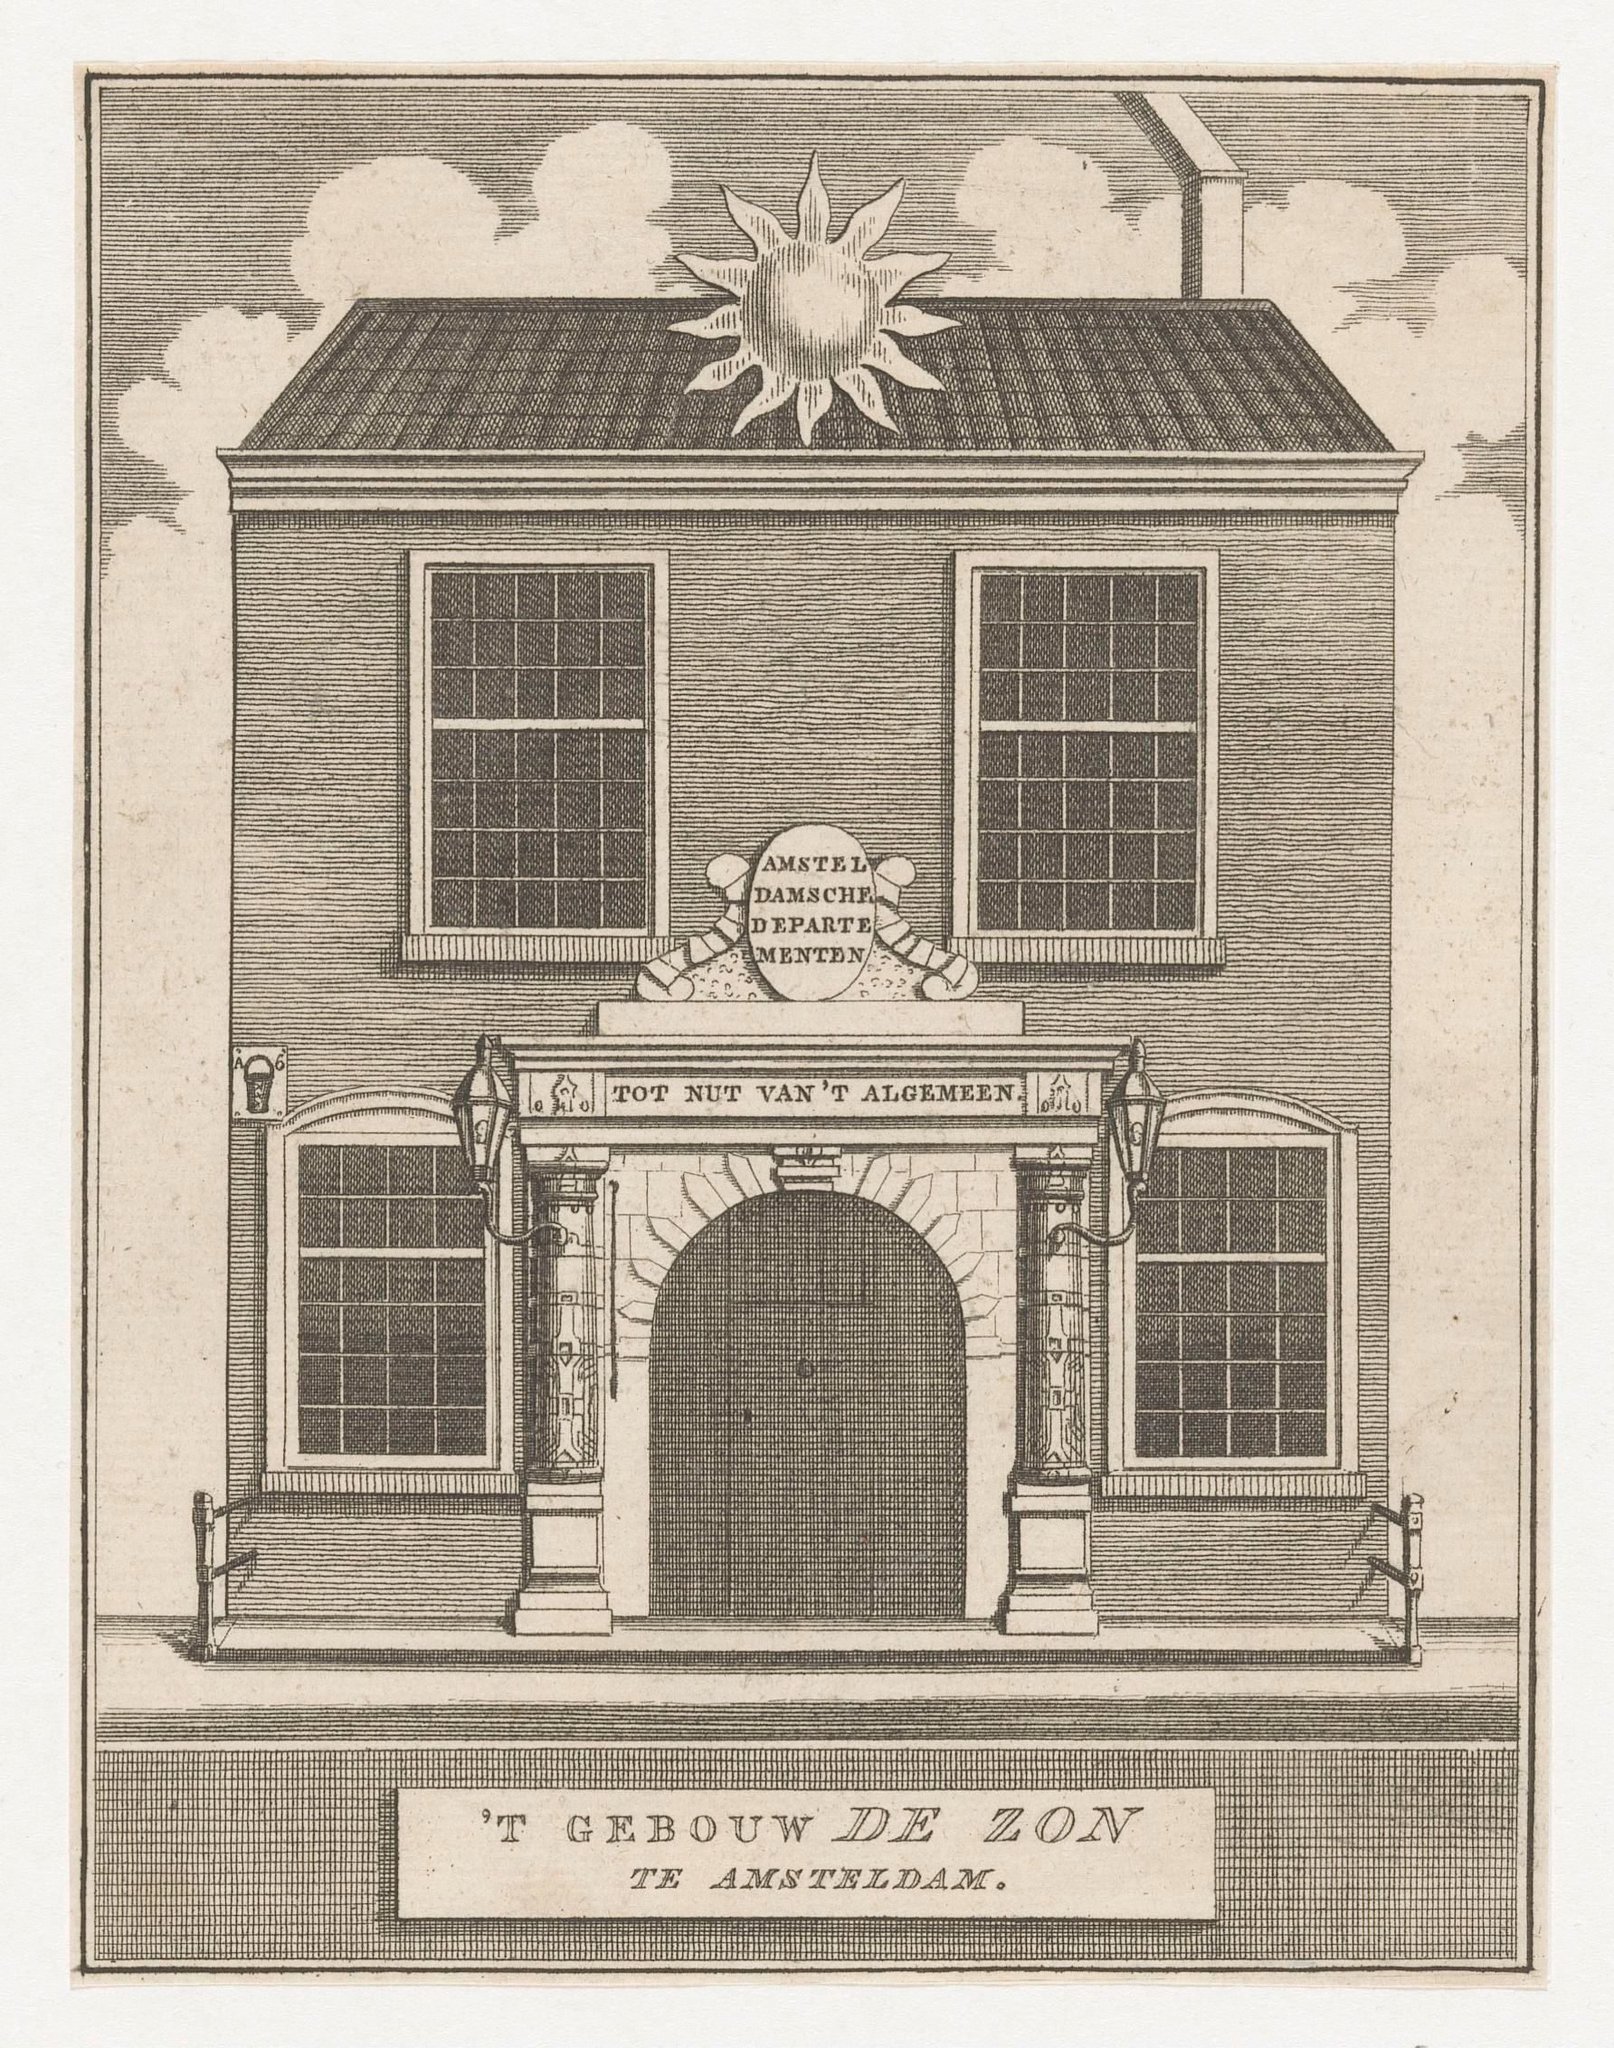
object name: print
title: Gezicht op het gebouw De Zon van de Maatschappij tot Nut van 't Algemeen te Amsterdam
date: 1802-1810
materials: paper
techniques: etching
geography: batavian republic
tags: façade (of house or building), amsterdam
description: Façade van het gebouw de Zon dat van 1801 tot 1823 in gebruik was door de Maatschappij tot nut van 't algemeen en voorheen een Doopsgezinde kerk was.